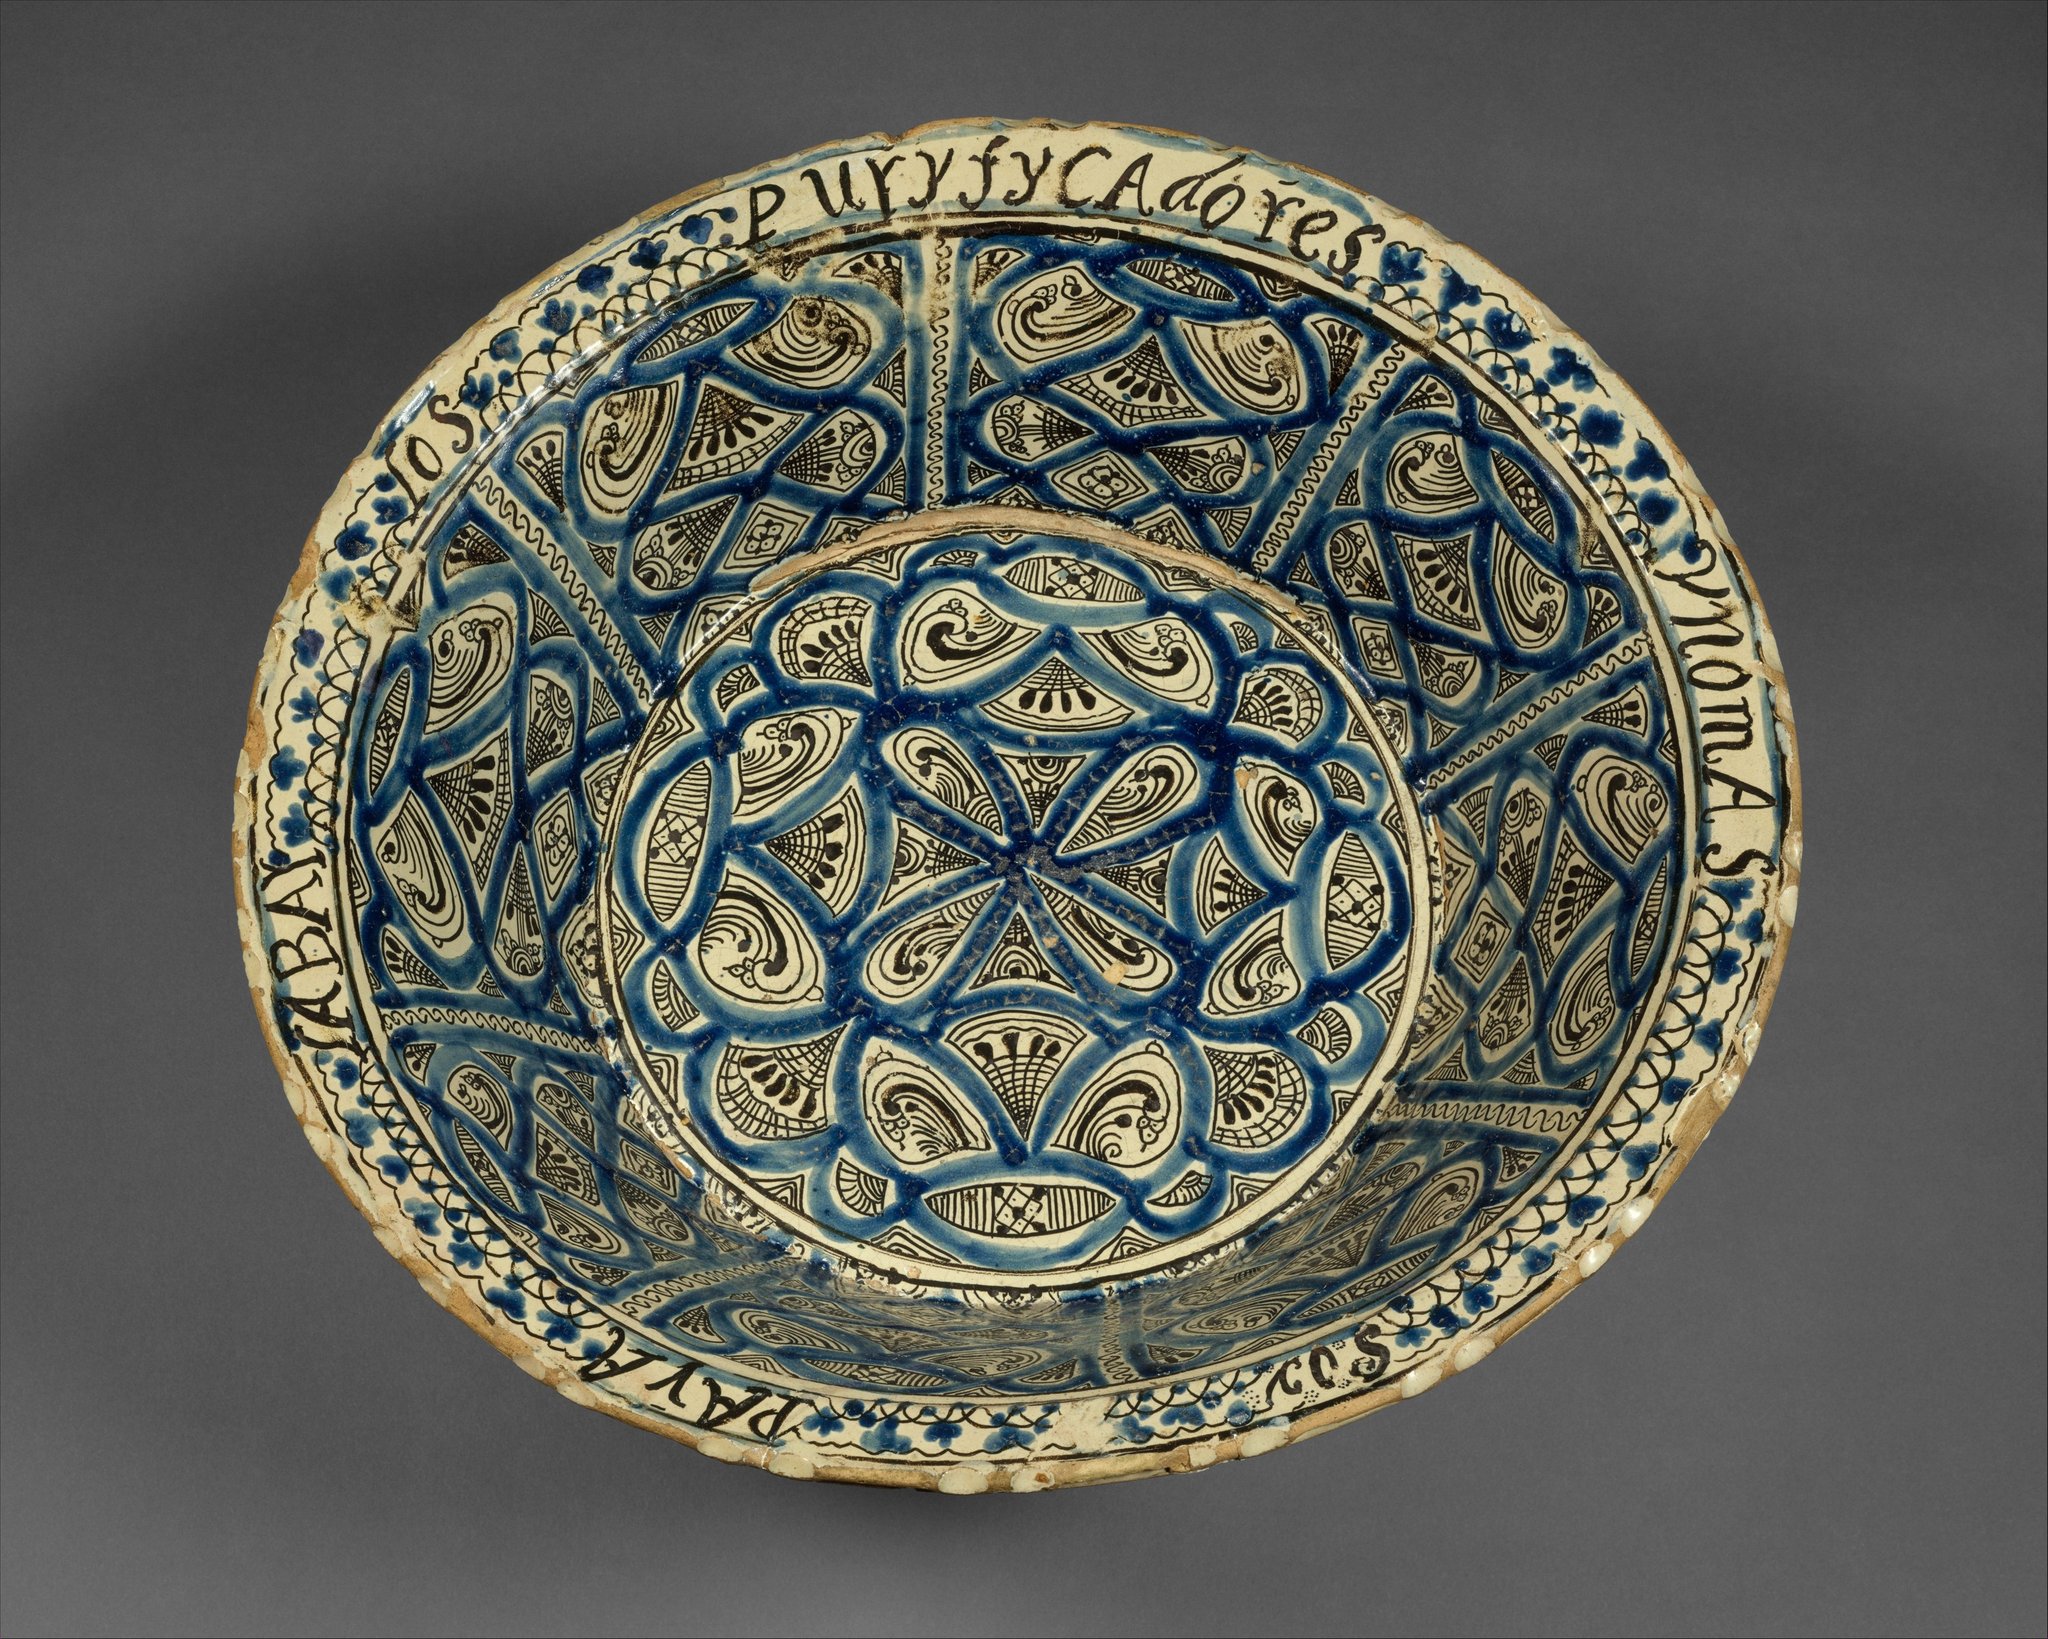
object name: basin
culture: mexican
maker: master potter a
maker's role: artist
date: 1650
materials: earthenware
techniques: glazing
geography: mexico